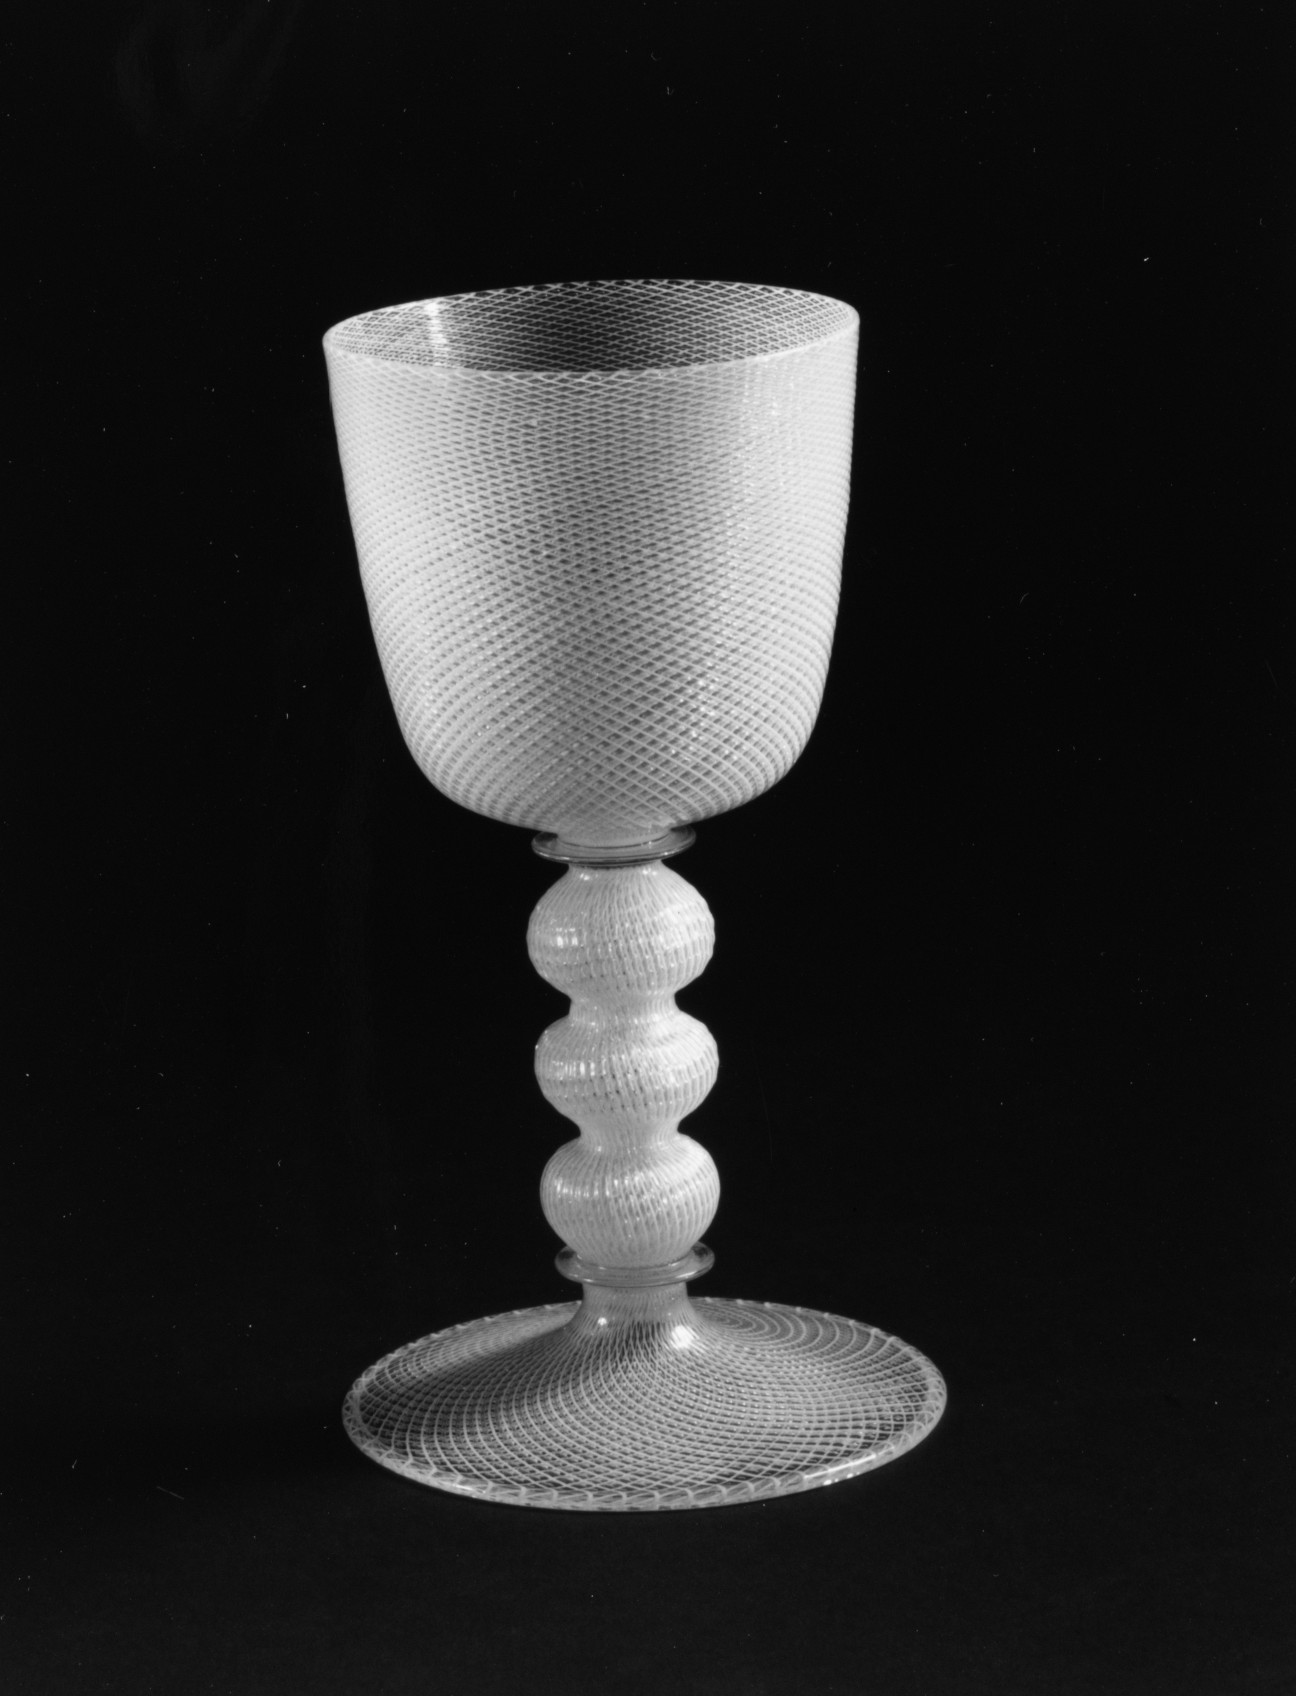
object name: goblet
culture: italian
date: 1667-1733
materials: glass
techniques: glassblowing